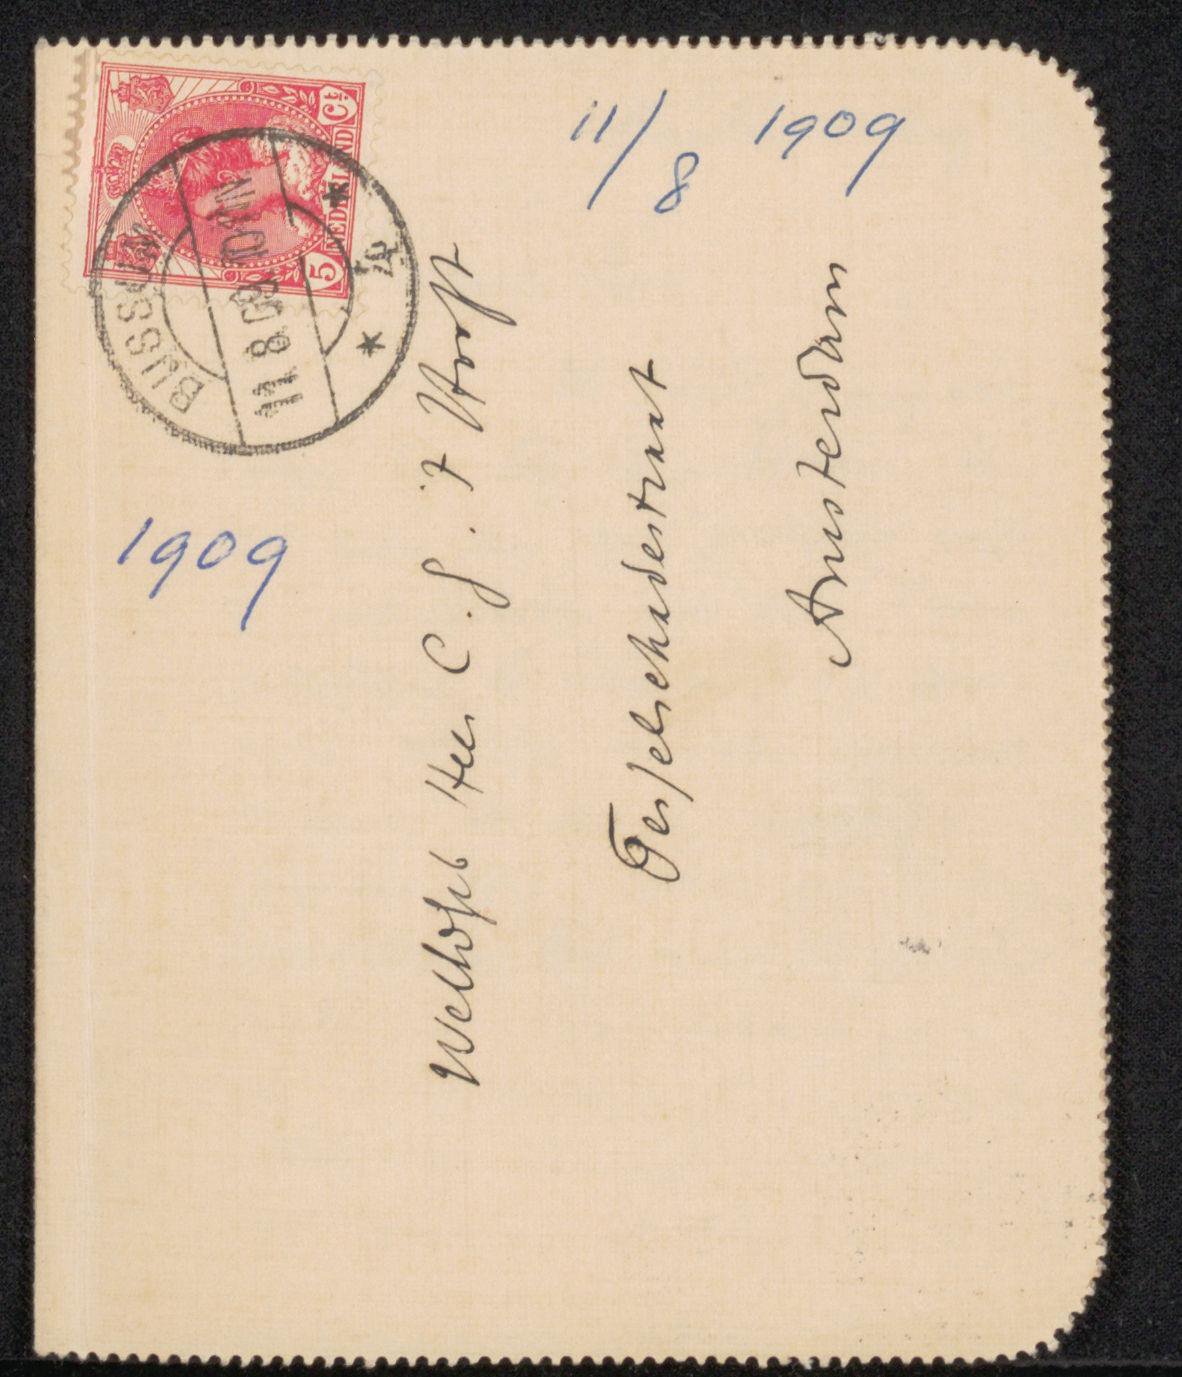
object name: letter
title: Brief aan Cornelis Gerardus 't Hooft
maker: jan veth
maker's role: designer, draughtsman, painter, print maker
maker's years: 1864-1925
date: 1909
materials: ink, paper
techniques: pen, writing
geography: bussum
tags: jozef israëls, the hague, london, painter, print maker, draughtsman, matthijs maris, arnhem, anton mauve, jacob maris, h.l. berckenhoff, cornelis gerardus 't hooft, painting (including book-illumination, miniature-painting), exhibition ~ art, printed matter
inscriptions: collector's mark: ‘RPK’